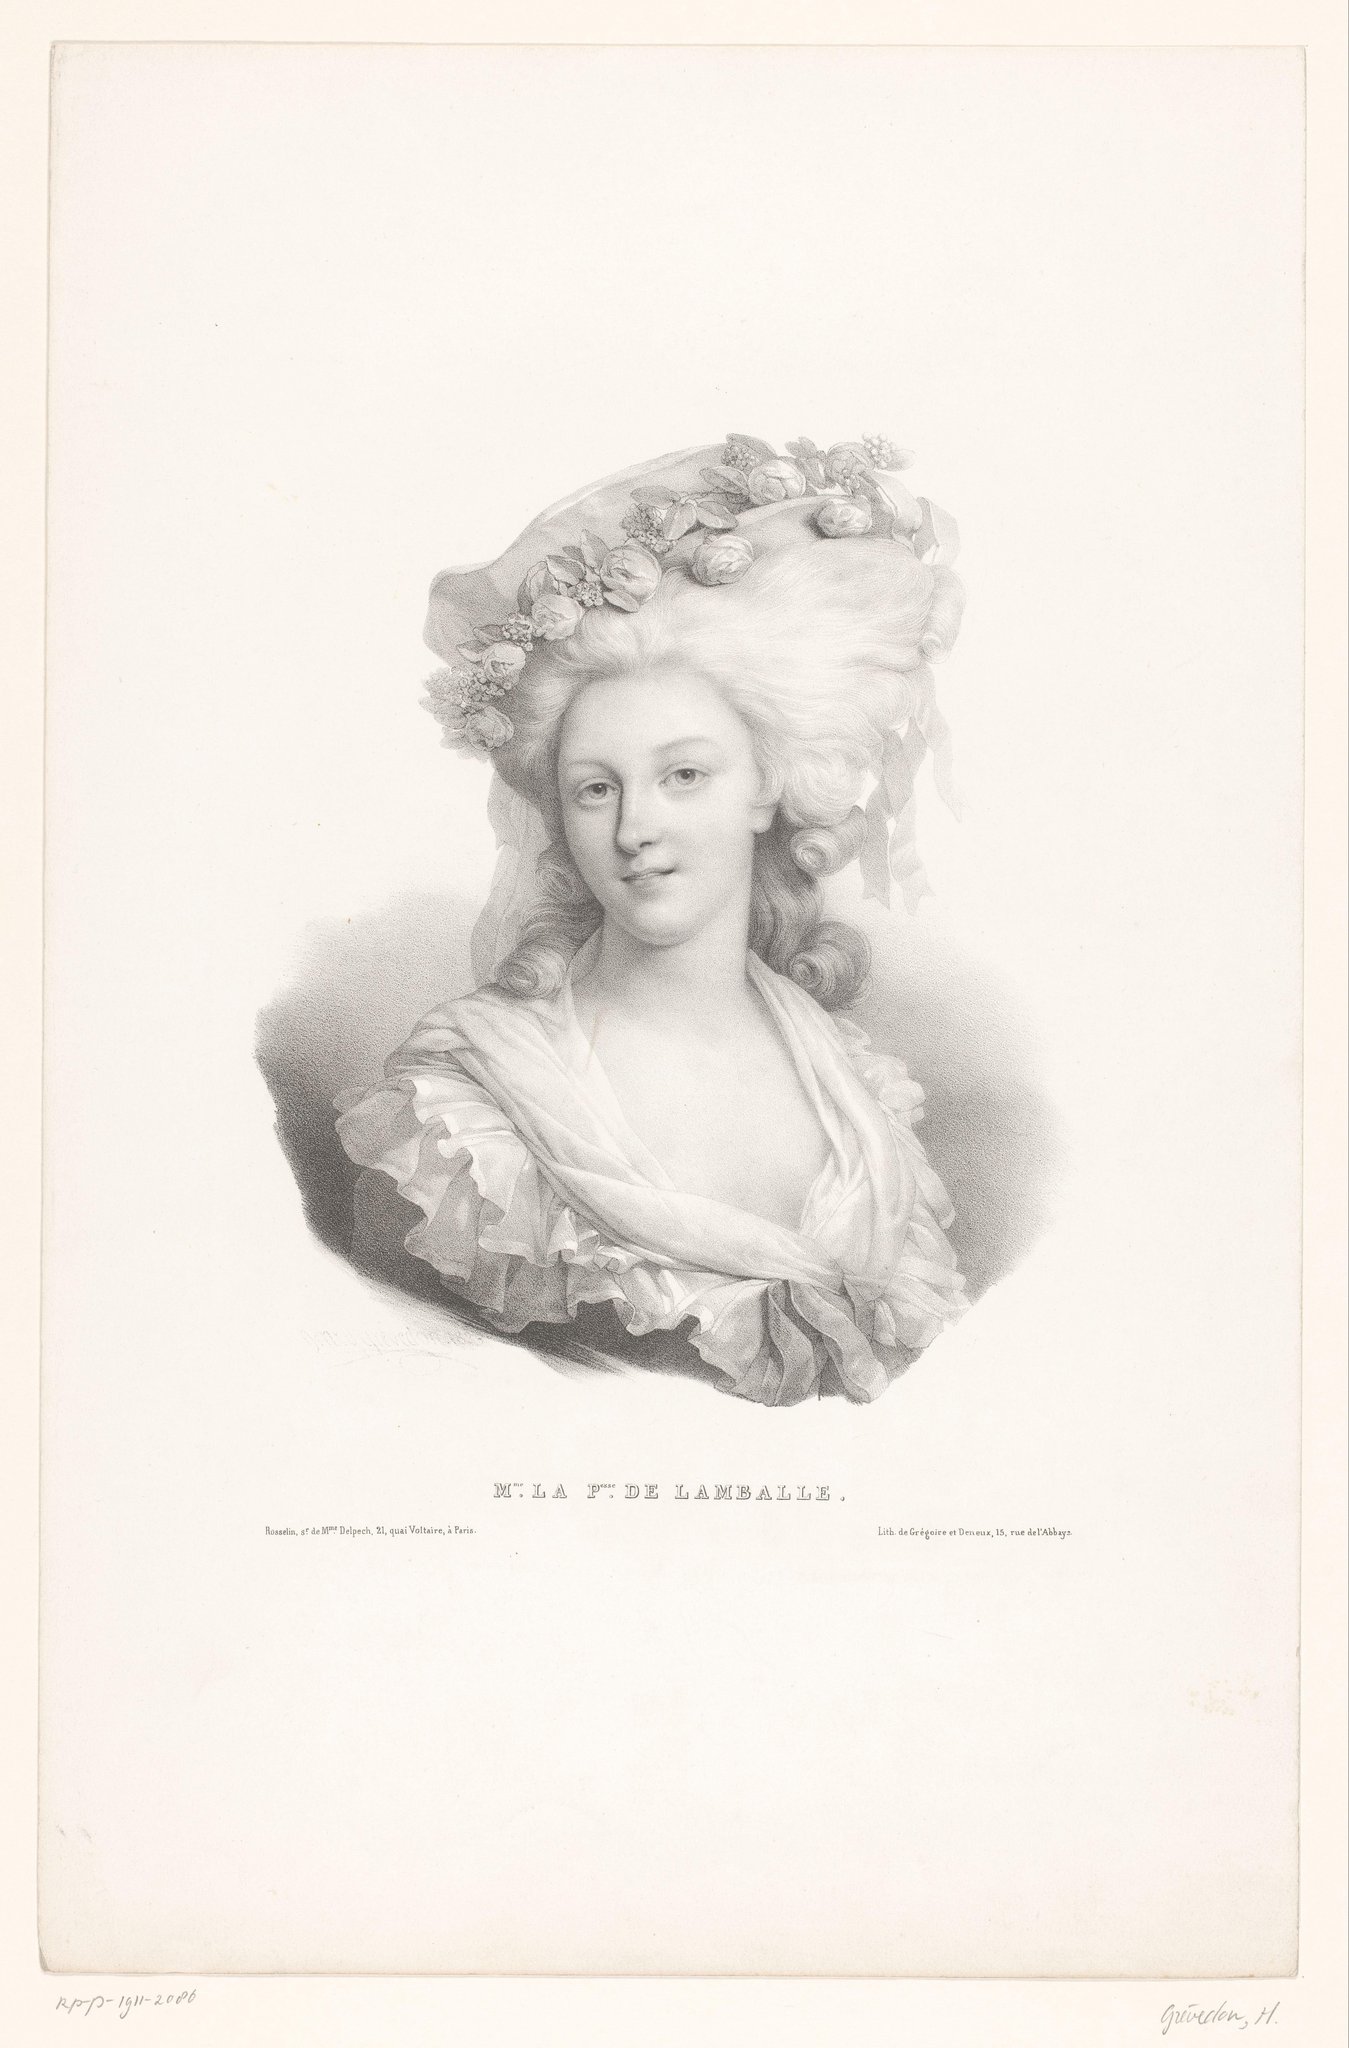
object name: print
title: Portret van Maria Louise van Savoye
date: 1843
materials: paper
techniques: lithograph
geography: paris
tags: paris, historical persons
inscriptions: collector's mark: Lugt 2228a